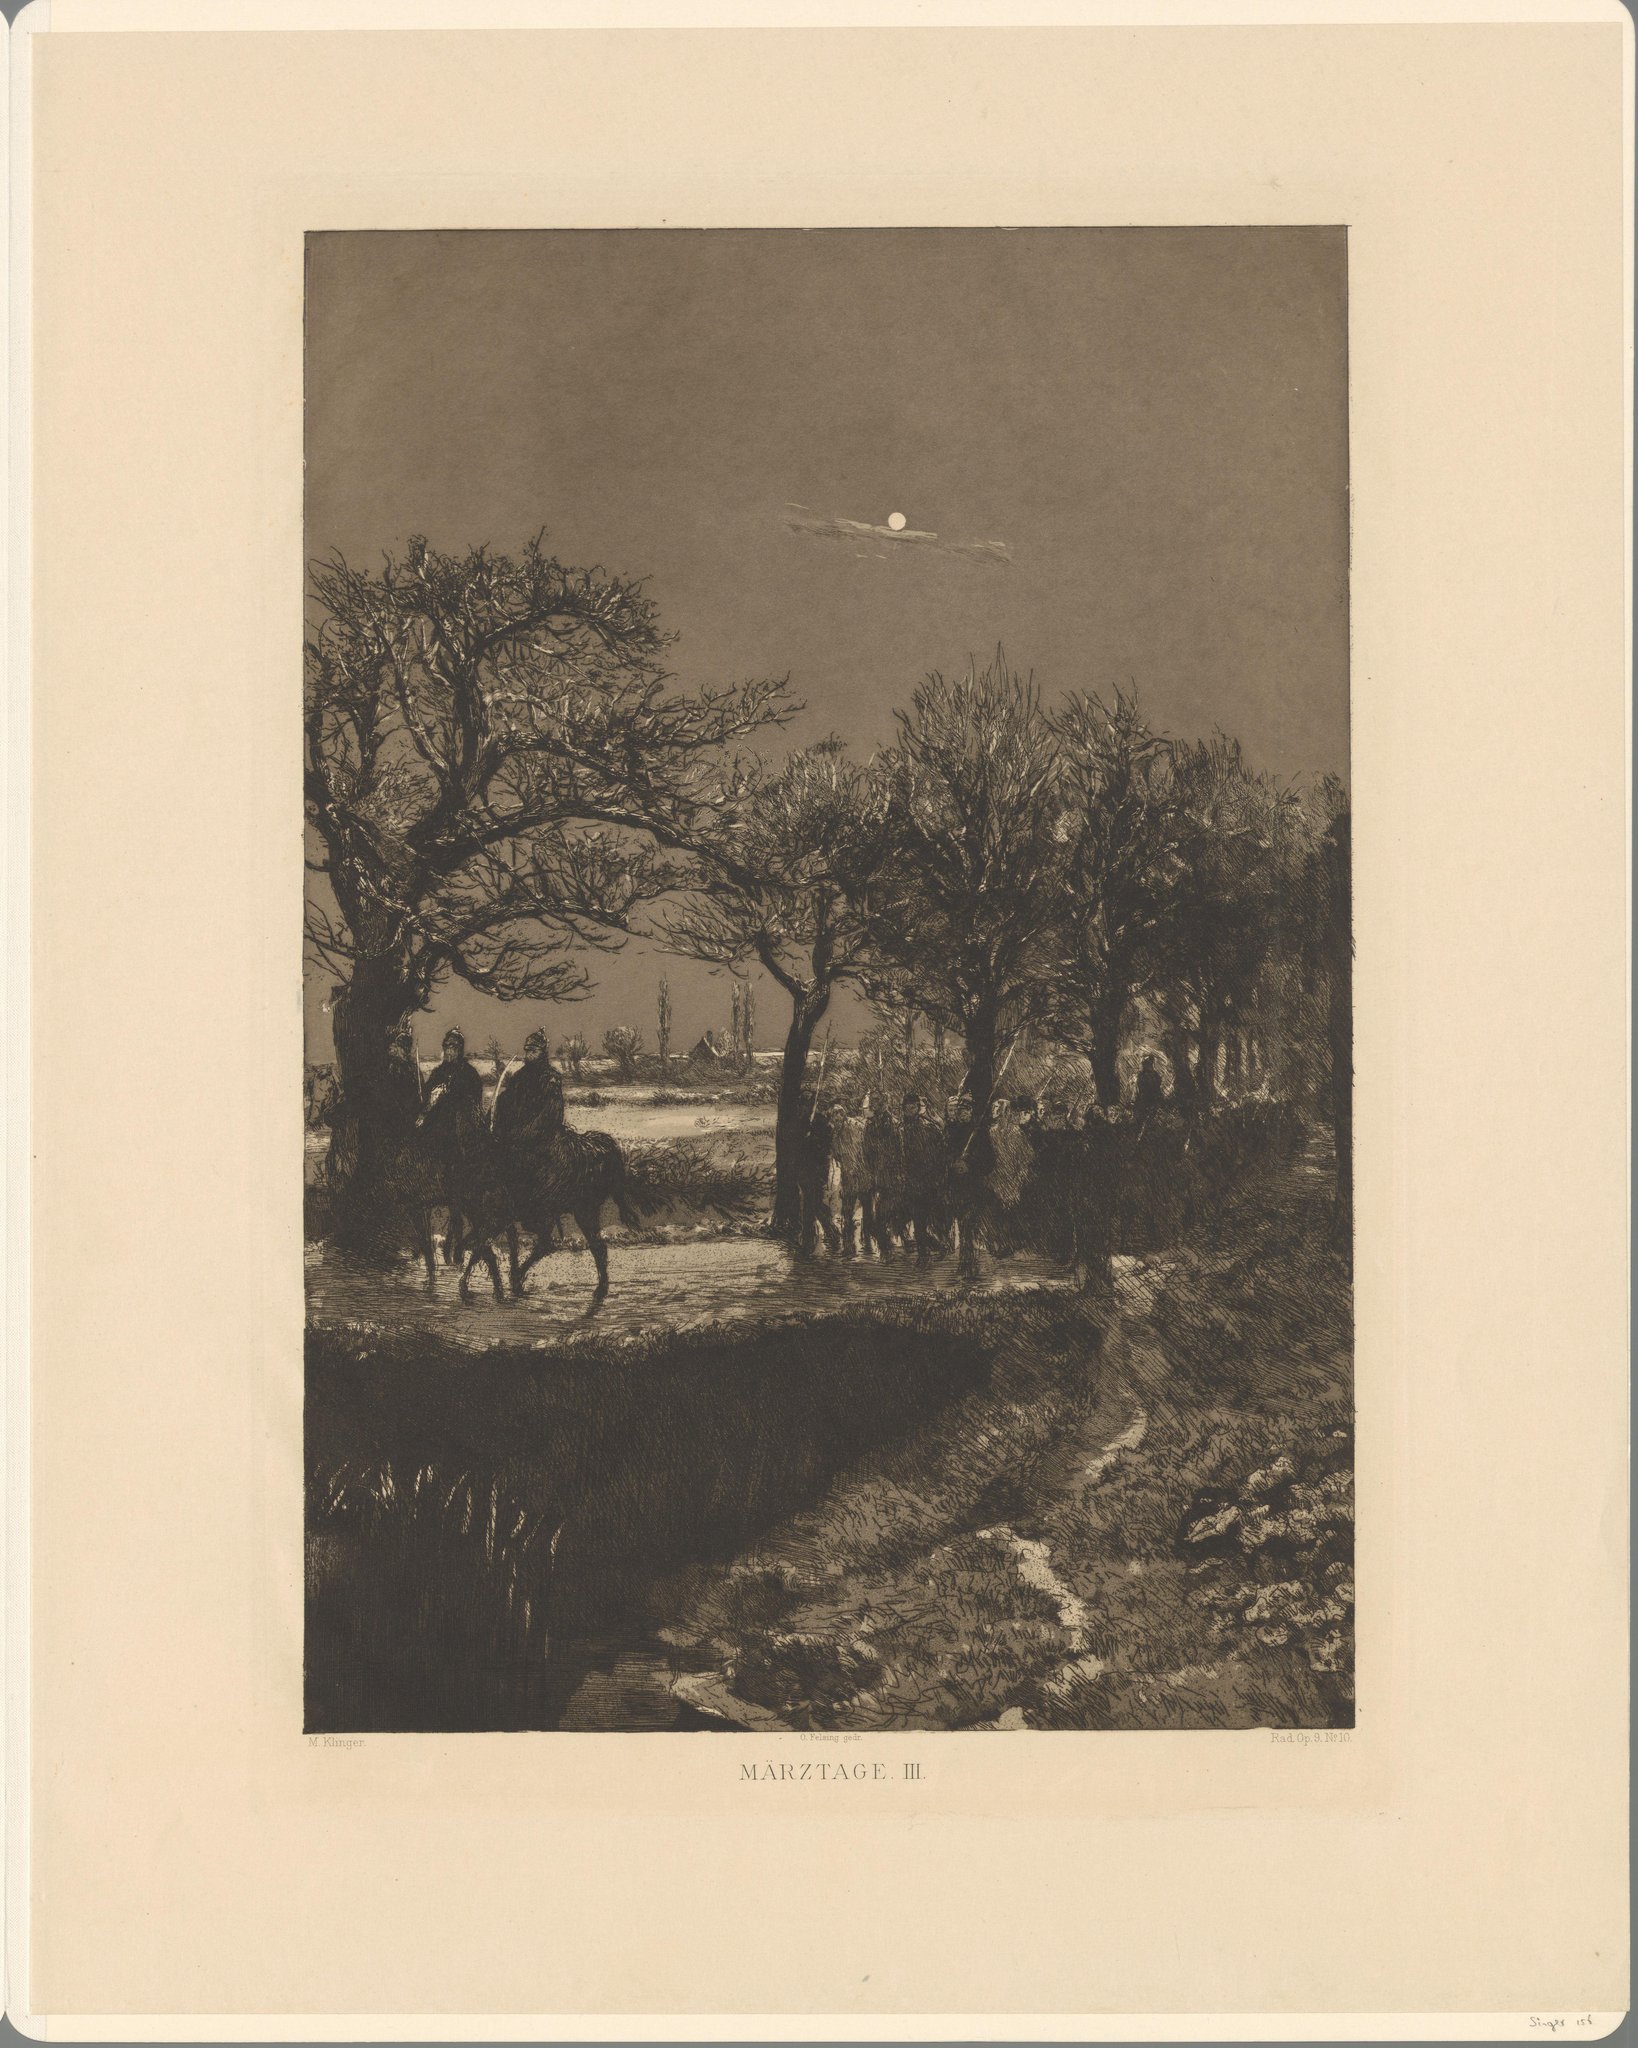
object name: print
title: Dramen (Opus IX)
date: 1883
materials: paper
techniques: aquatint, drypoint, etching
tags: full moon, helved weapons, polearms (for striking, hacking, thrusting): pike, transfer, deportation ~ prisoner of war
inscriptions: collector's mark: Lugt 2228, annotation: ‘Rad. Op. 9 No. 10’, collector's mark: Lugt 2760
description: Deze prent hoort bij een serie getitleld 'Dramen (Opus IX)' van tien prenten door Max Klinger, geïnspireerd door teksten van Emil Zola, met zes maatschappelijke tragediën ten tijde van de industriële revolutie in Duitsland rond 1880. Vooral thema's van jaloezie, sociaal klassenverschil, ellende en de melancholie van industrialisatie in Berlijn worden belicht. De zin 'Doch uns ist gegeben auf keiner Stätte zu ruh'n' (vrij vertaald: 'We krijgen toch nergens rust') uit het gedicht 'Schicksalslied' door Friedrich Hölderlin vormt de onderliggende boodschap van deze serie. De prenten zijn in 1883 gedrukt door Otto Felsing, in vijf edities en 200 sets.